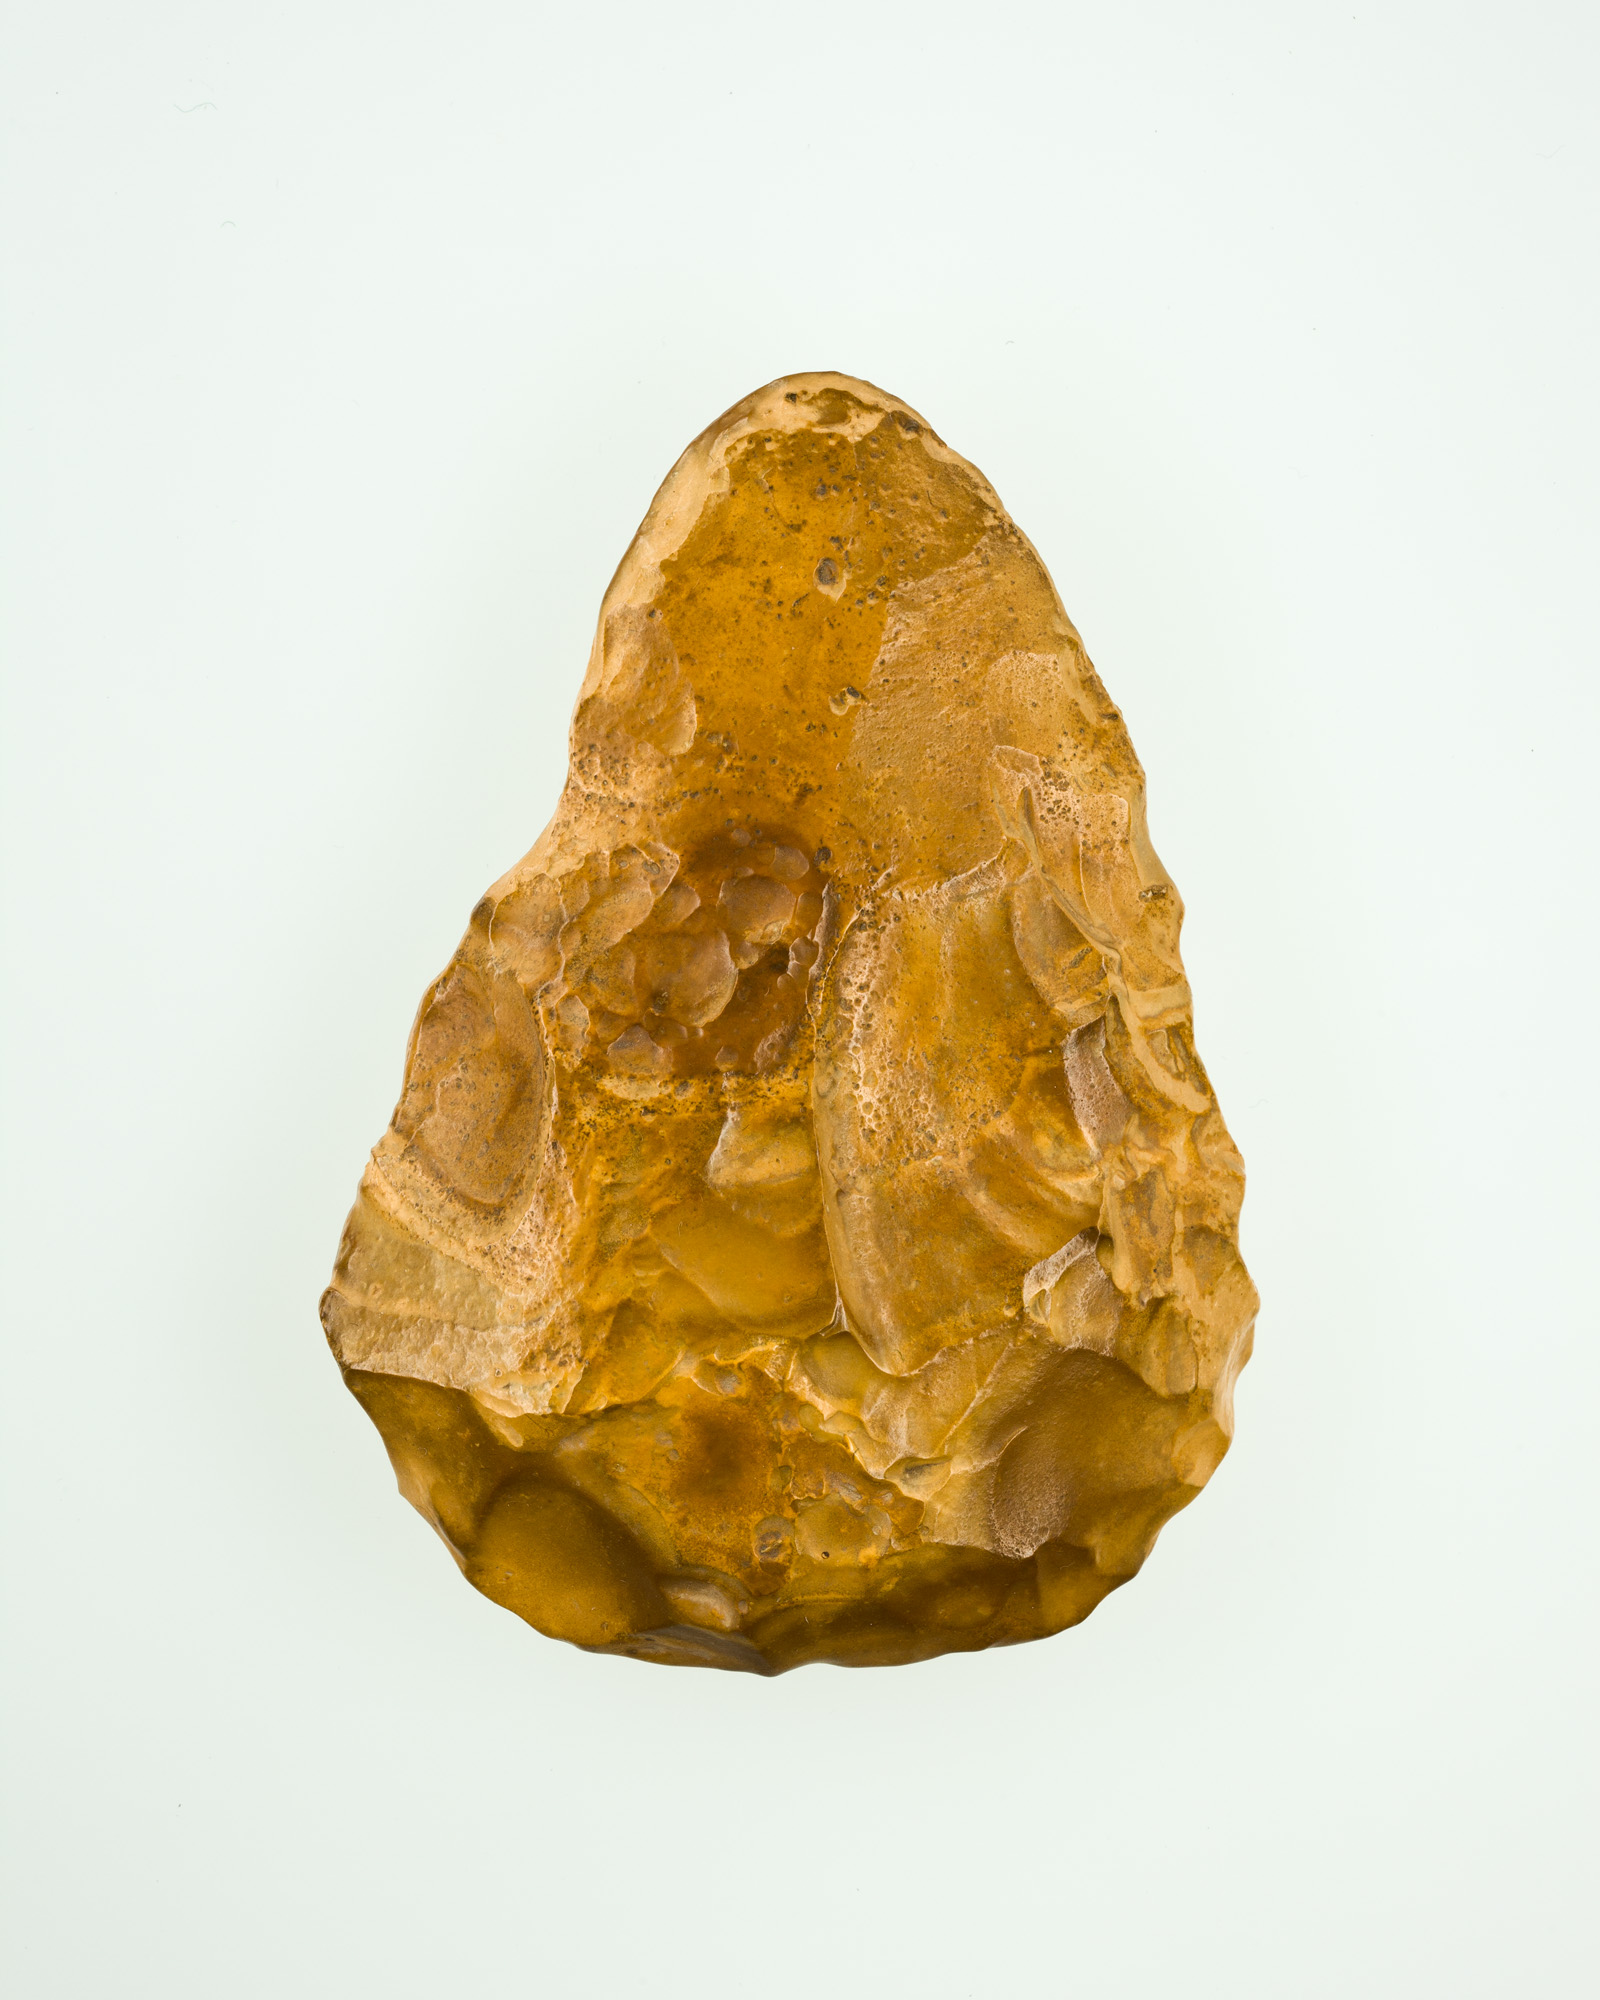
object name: biface, hand ax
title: Biface, commonly referred to as a hand ax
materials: stone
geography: egypt